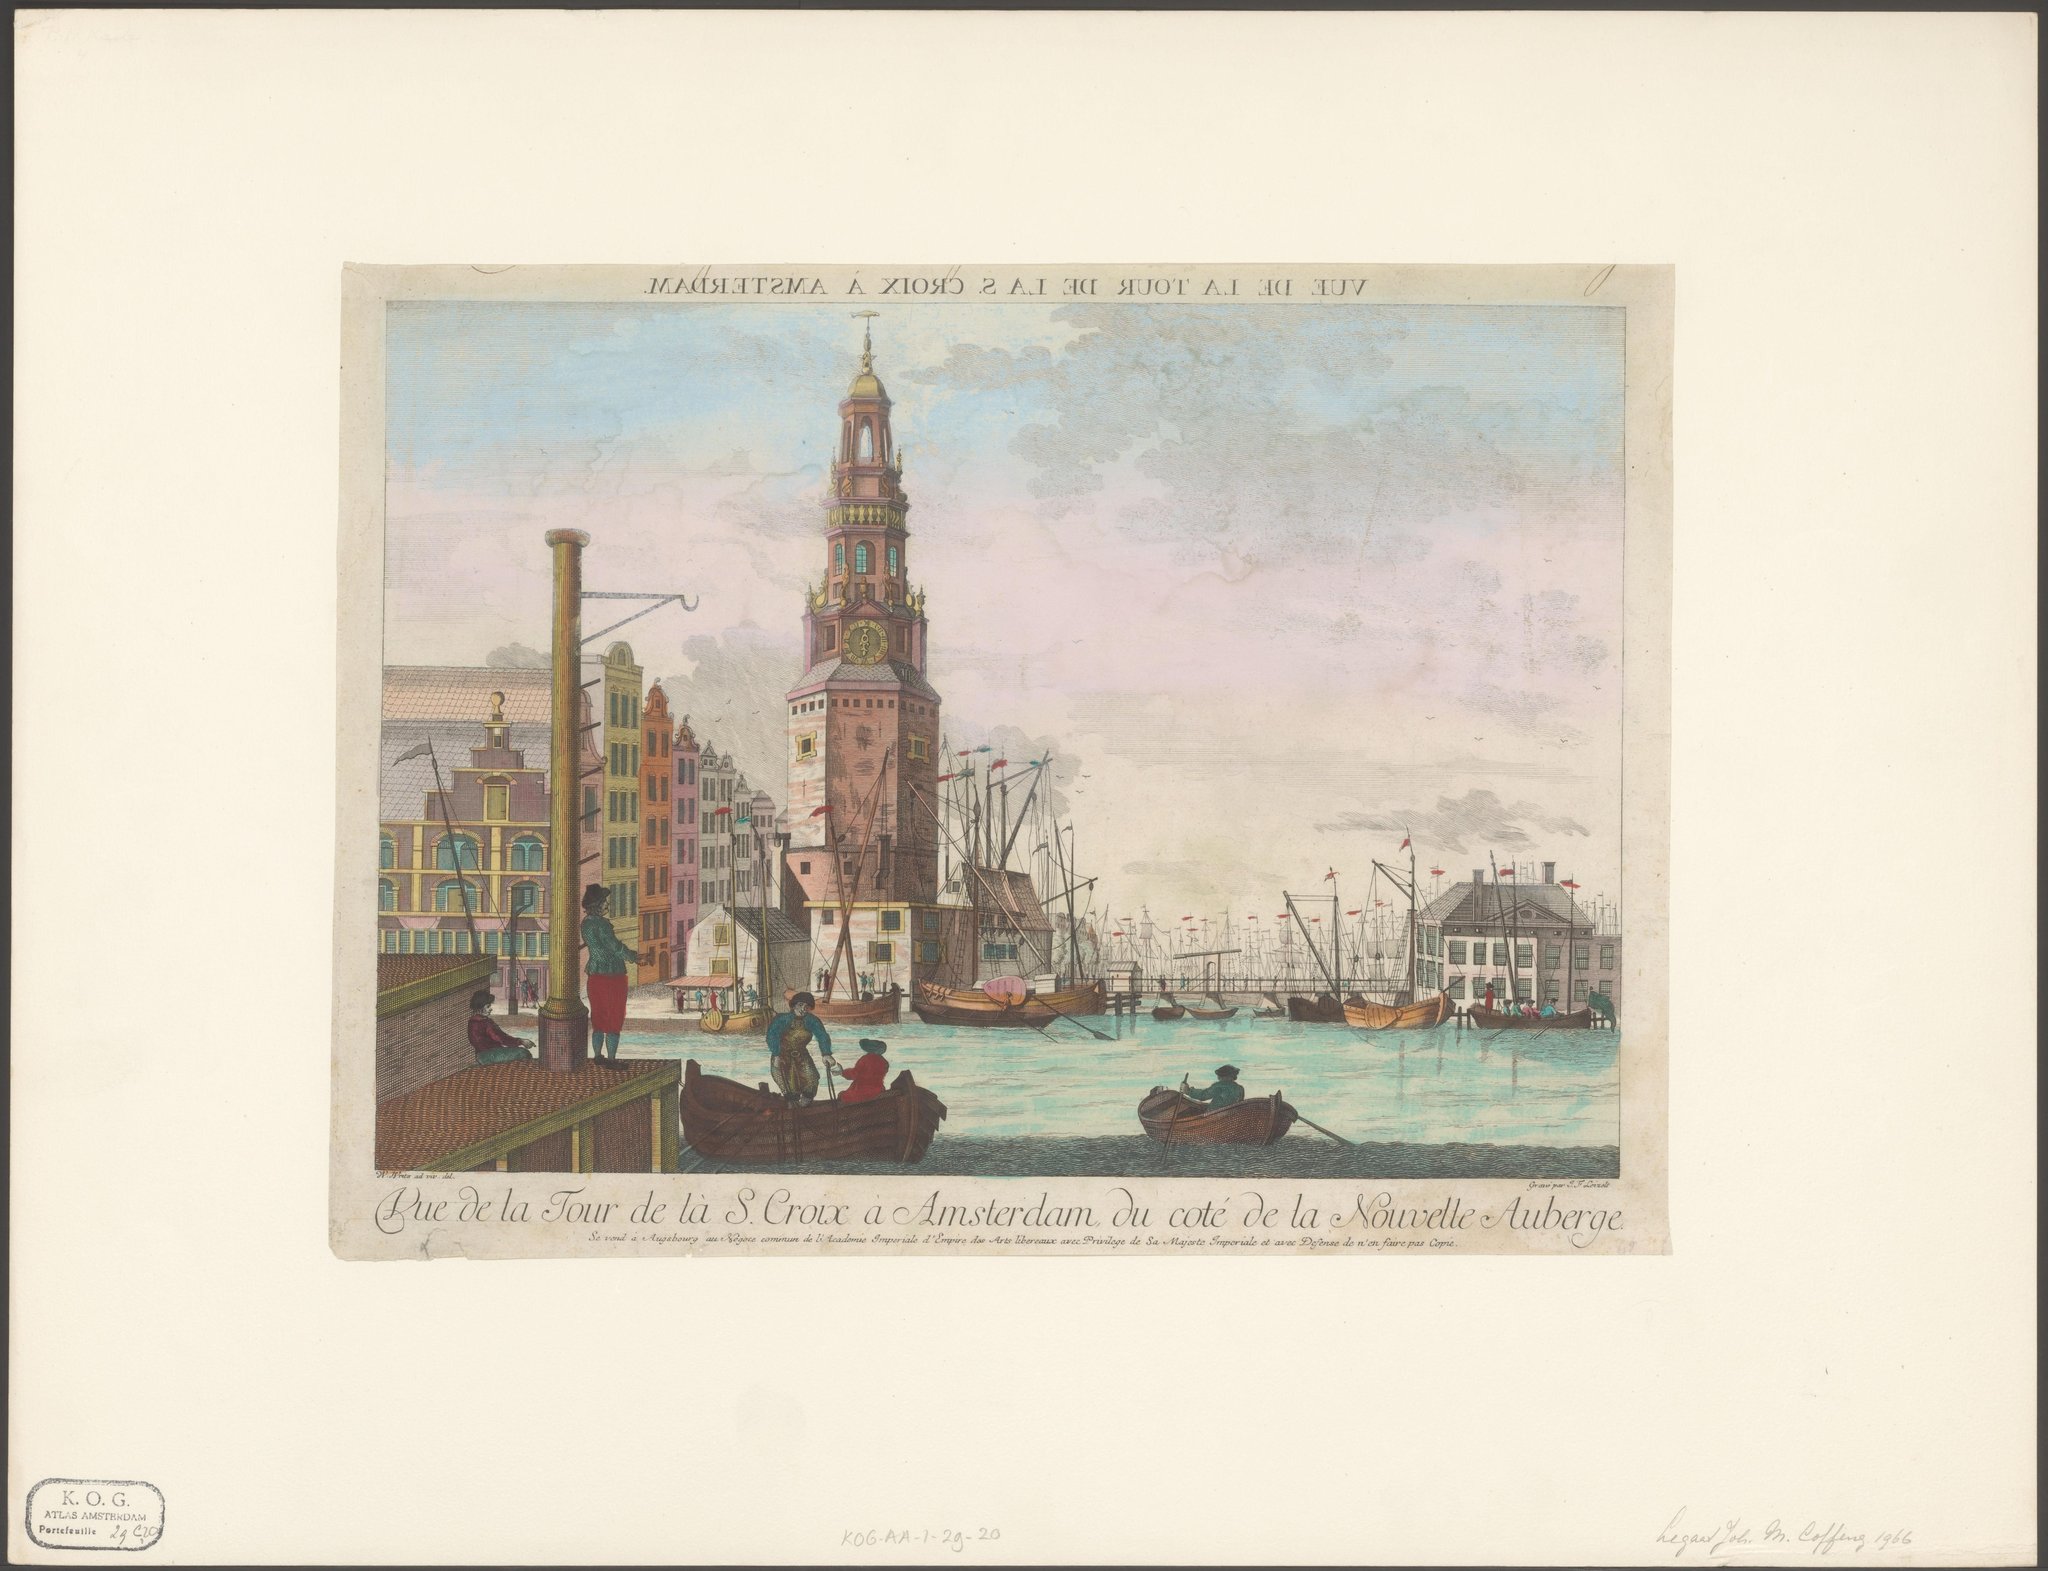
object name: print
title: Gezicht op de Haringpakkerstoren te Amsterdam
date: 1755-1779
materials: paper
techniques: engraving, etching, hand coloring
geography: amsterdam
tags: tower, clock tower ~ monumental adornment, rowing-boat, canoe, etc., canals, waters (in city)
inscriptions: collector's mark: Lugt 1641b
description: Onderwerpsrubriek binnen de Atlas Amsterdam: Haringpakkerstoren.